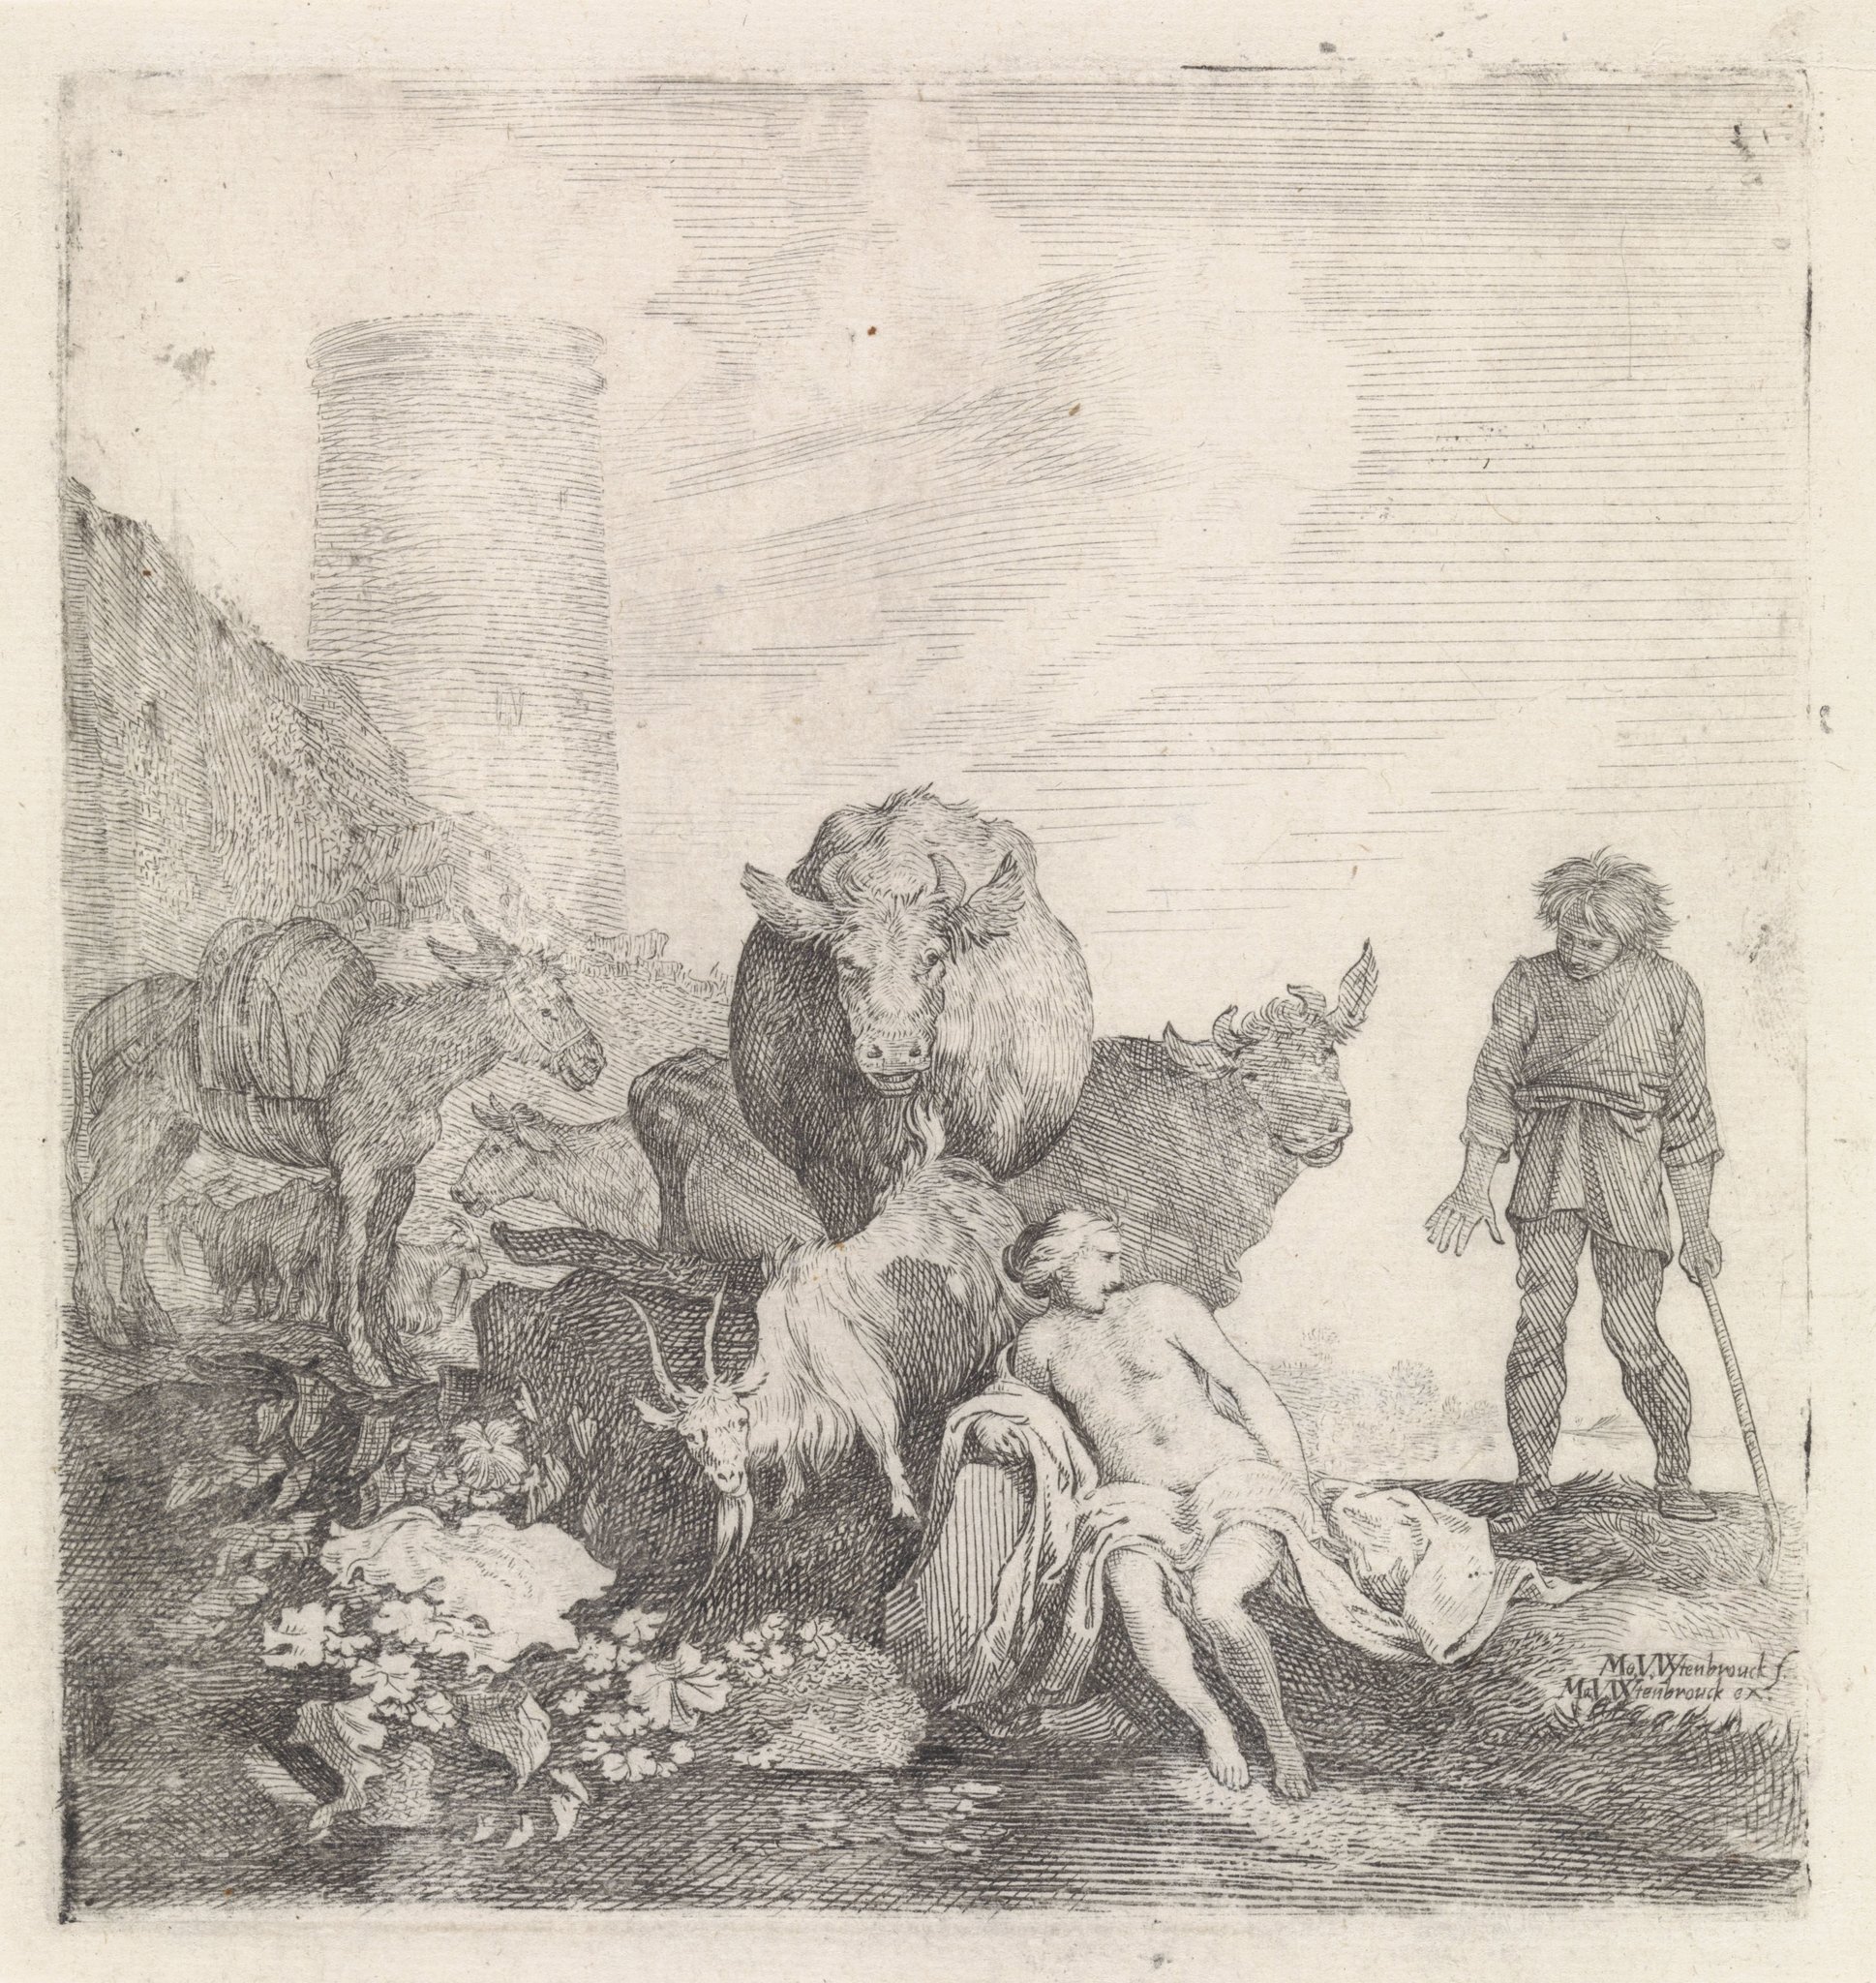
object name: print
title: Vrouw verrast bij het baden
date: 1600-1647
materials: paper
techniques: engraving, etching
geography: the hague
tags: public baths - aa - in the open air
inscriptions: collector's mark: Lugt 240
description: Een vrouw aan de rand van het water deinst terug terwijl ze opkijkt naar een man met herdersstaf. Achter haar een kudde met koeien, geiten en een bepakte ezel. Op de achtergrond een ronde toren.